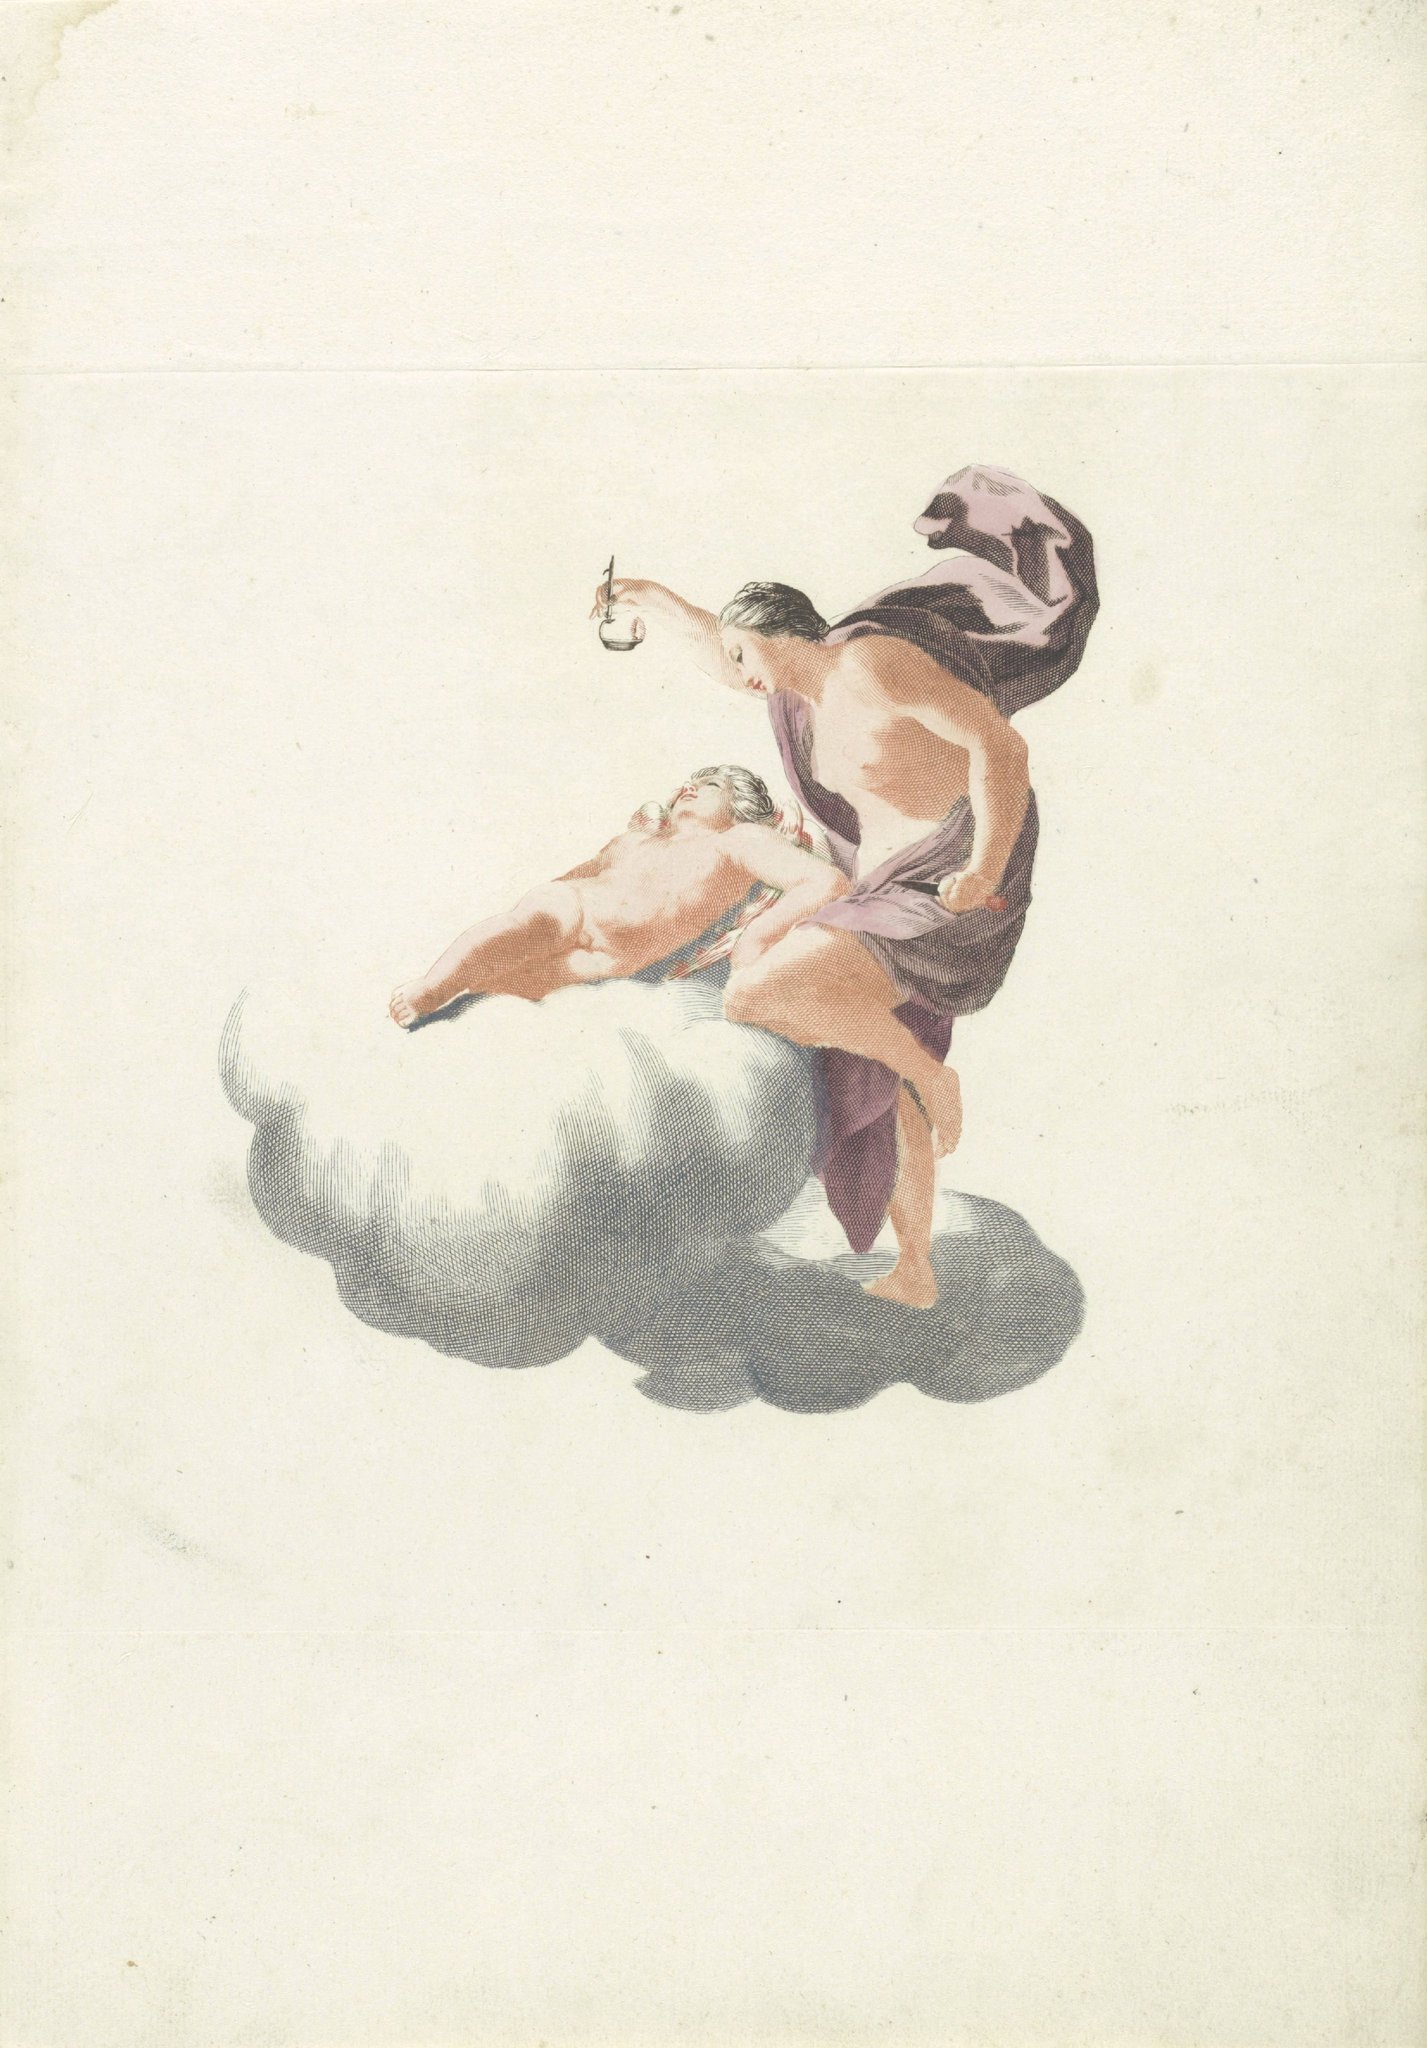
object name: print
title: Amor en Psyche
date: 1688-1698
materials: paper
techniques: printing, engraving, hand coloring, lithography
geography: netherlands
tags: psyche, holding a lamp, gazes at the sleeping cupid, who awakens when a drop of hot oil falls on him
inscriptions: collector's mark: Lugt 2760, collector's mark: Lugt 2228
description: Psyche bespiedt de god Amor in zijn slaap. Zij heeft een olielamp en een dolk in haar handen. Psyche schrikt door de schoonheid van Amor en knoeit een druppel olie uit haar lamp, waardoor hij zal ontwaken.